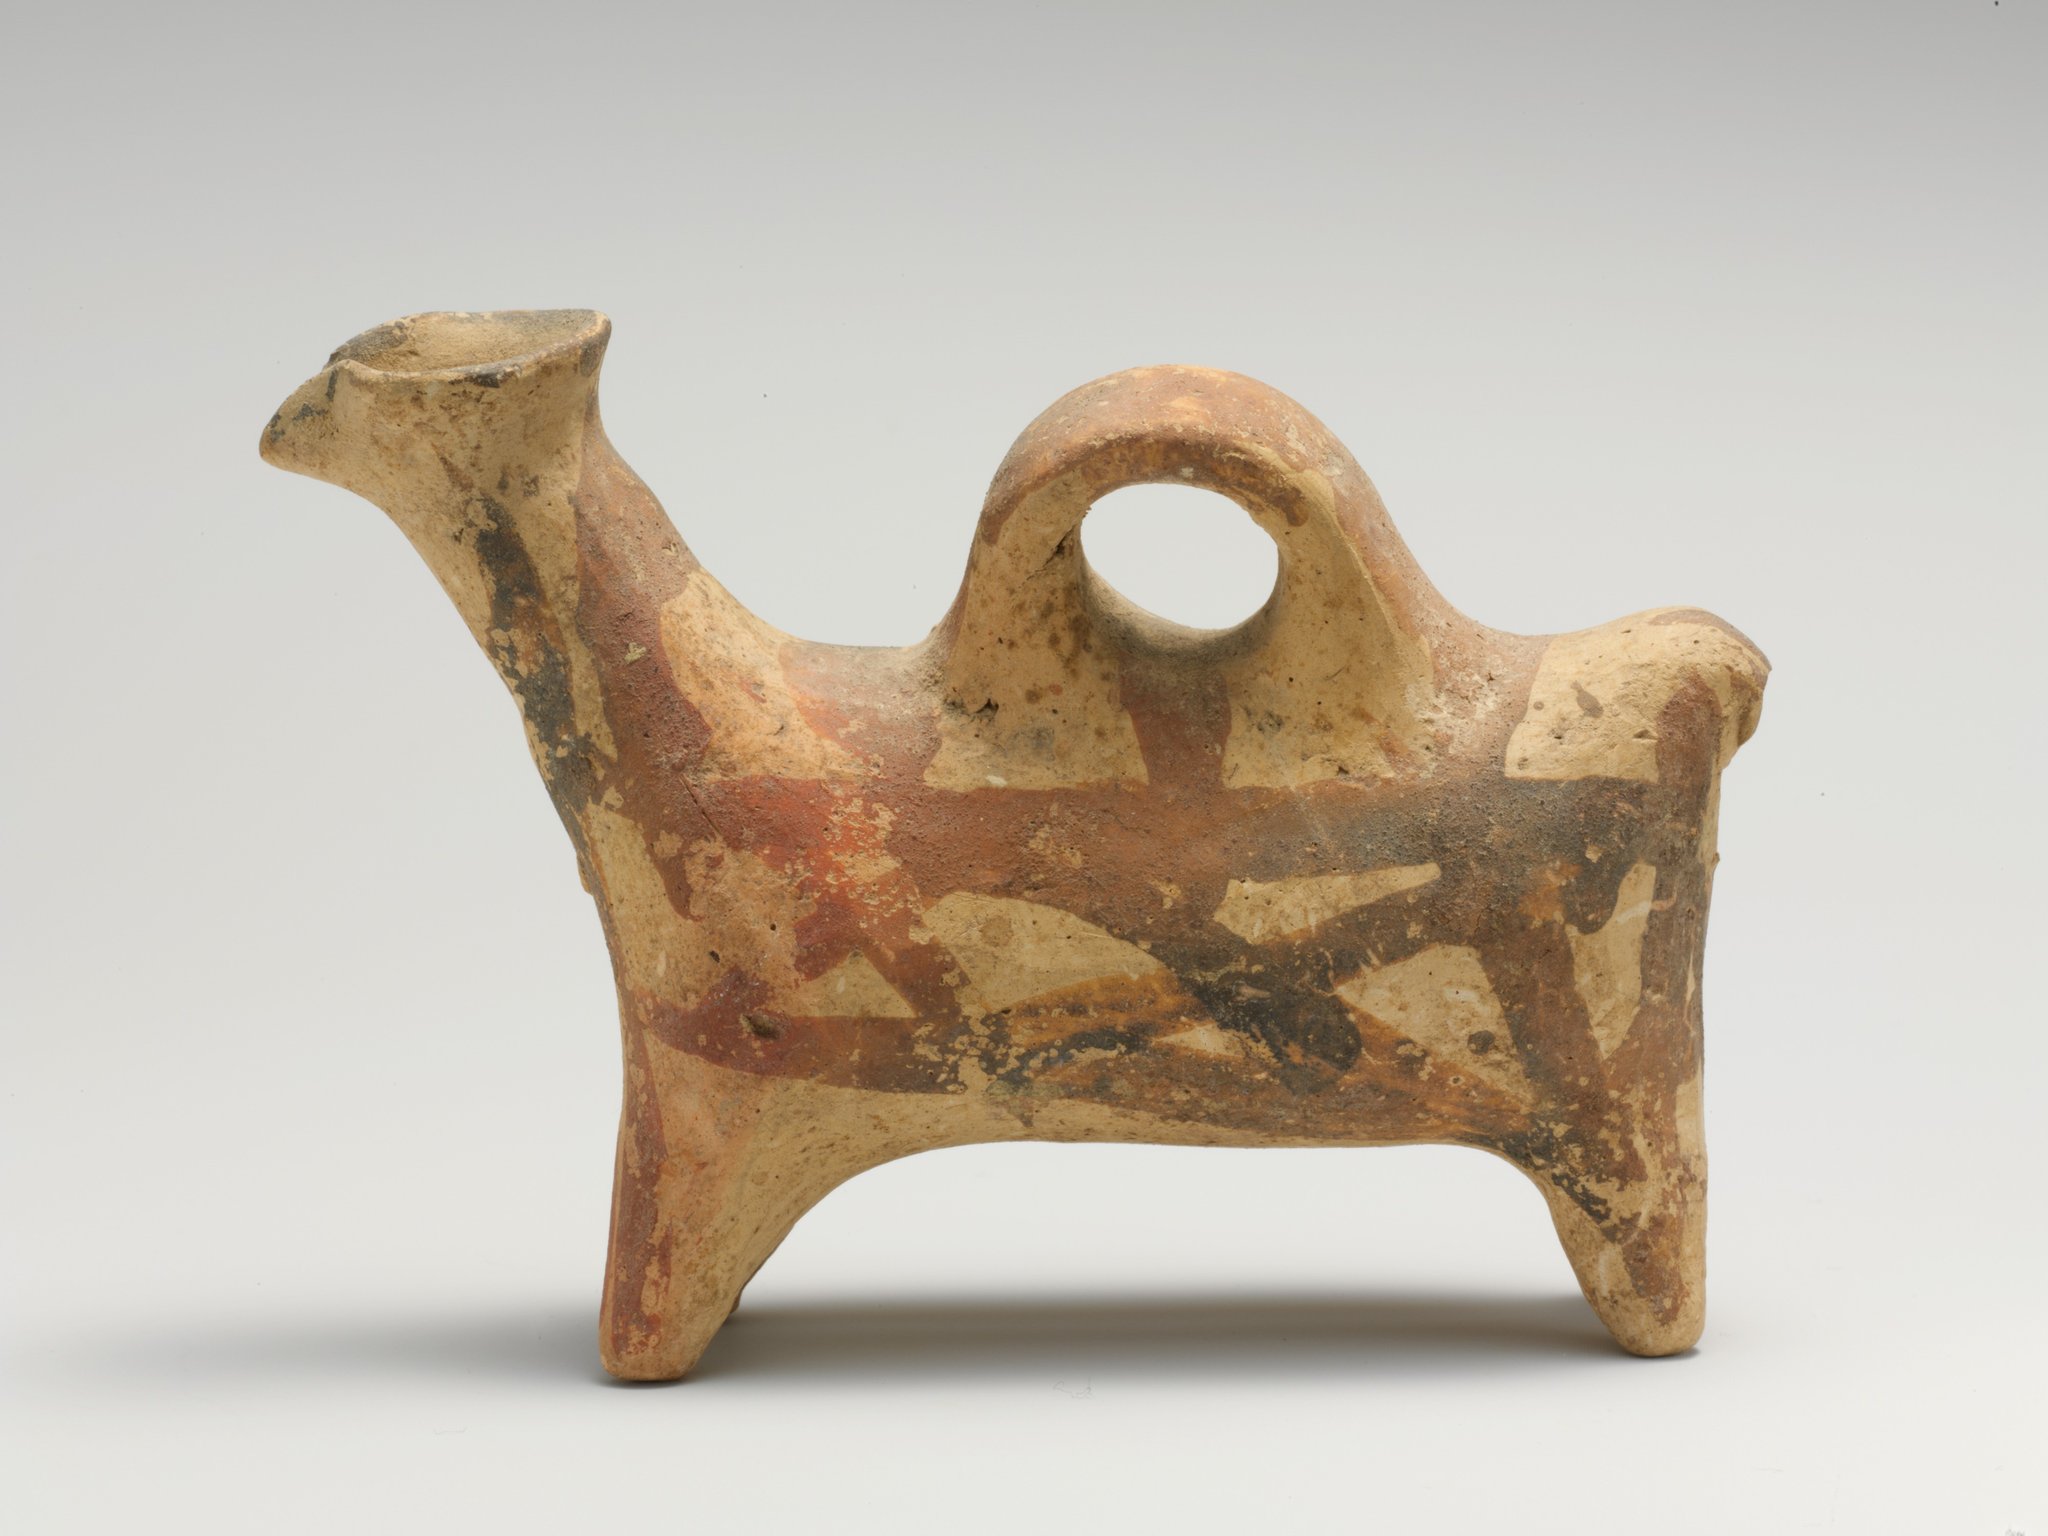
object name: askos in the form of an animal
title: Terracotta zoomorphic askos (vessel)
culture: cypriot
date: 1900-1600 BCE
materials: terracotta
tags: animals